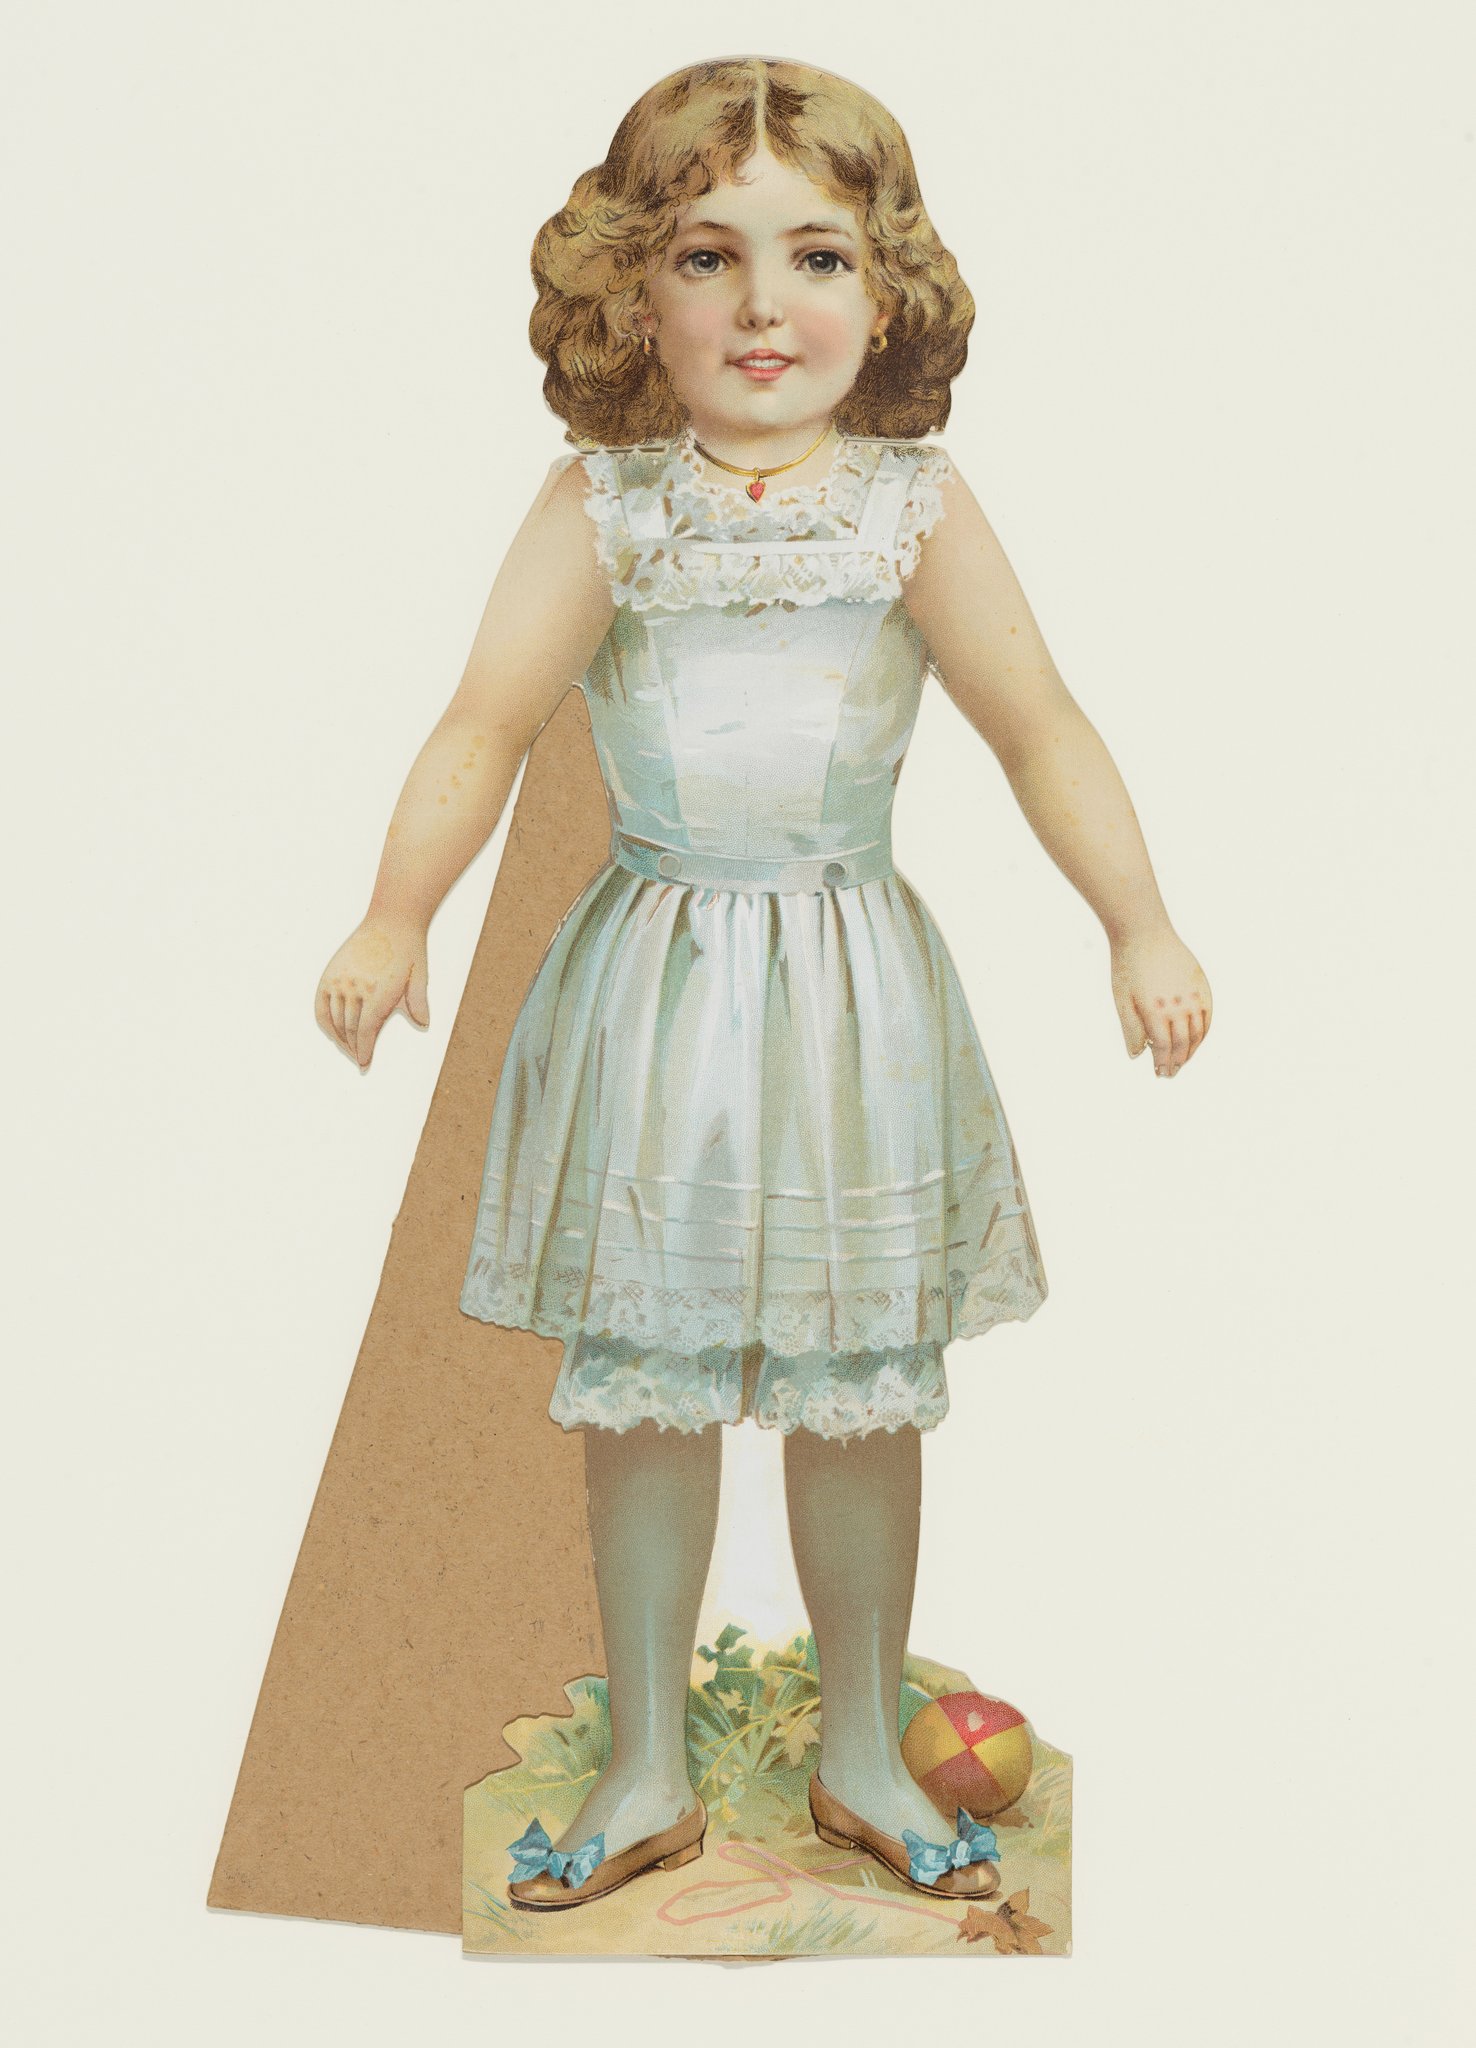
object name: paper doll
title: Our Favorite Dolls: Paper Doll in Lacy Underdress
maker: selchow and righter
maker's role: publisher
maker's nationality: american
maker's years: 1880-1986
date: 1900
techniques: lithograph